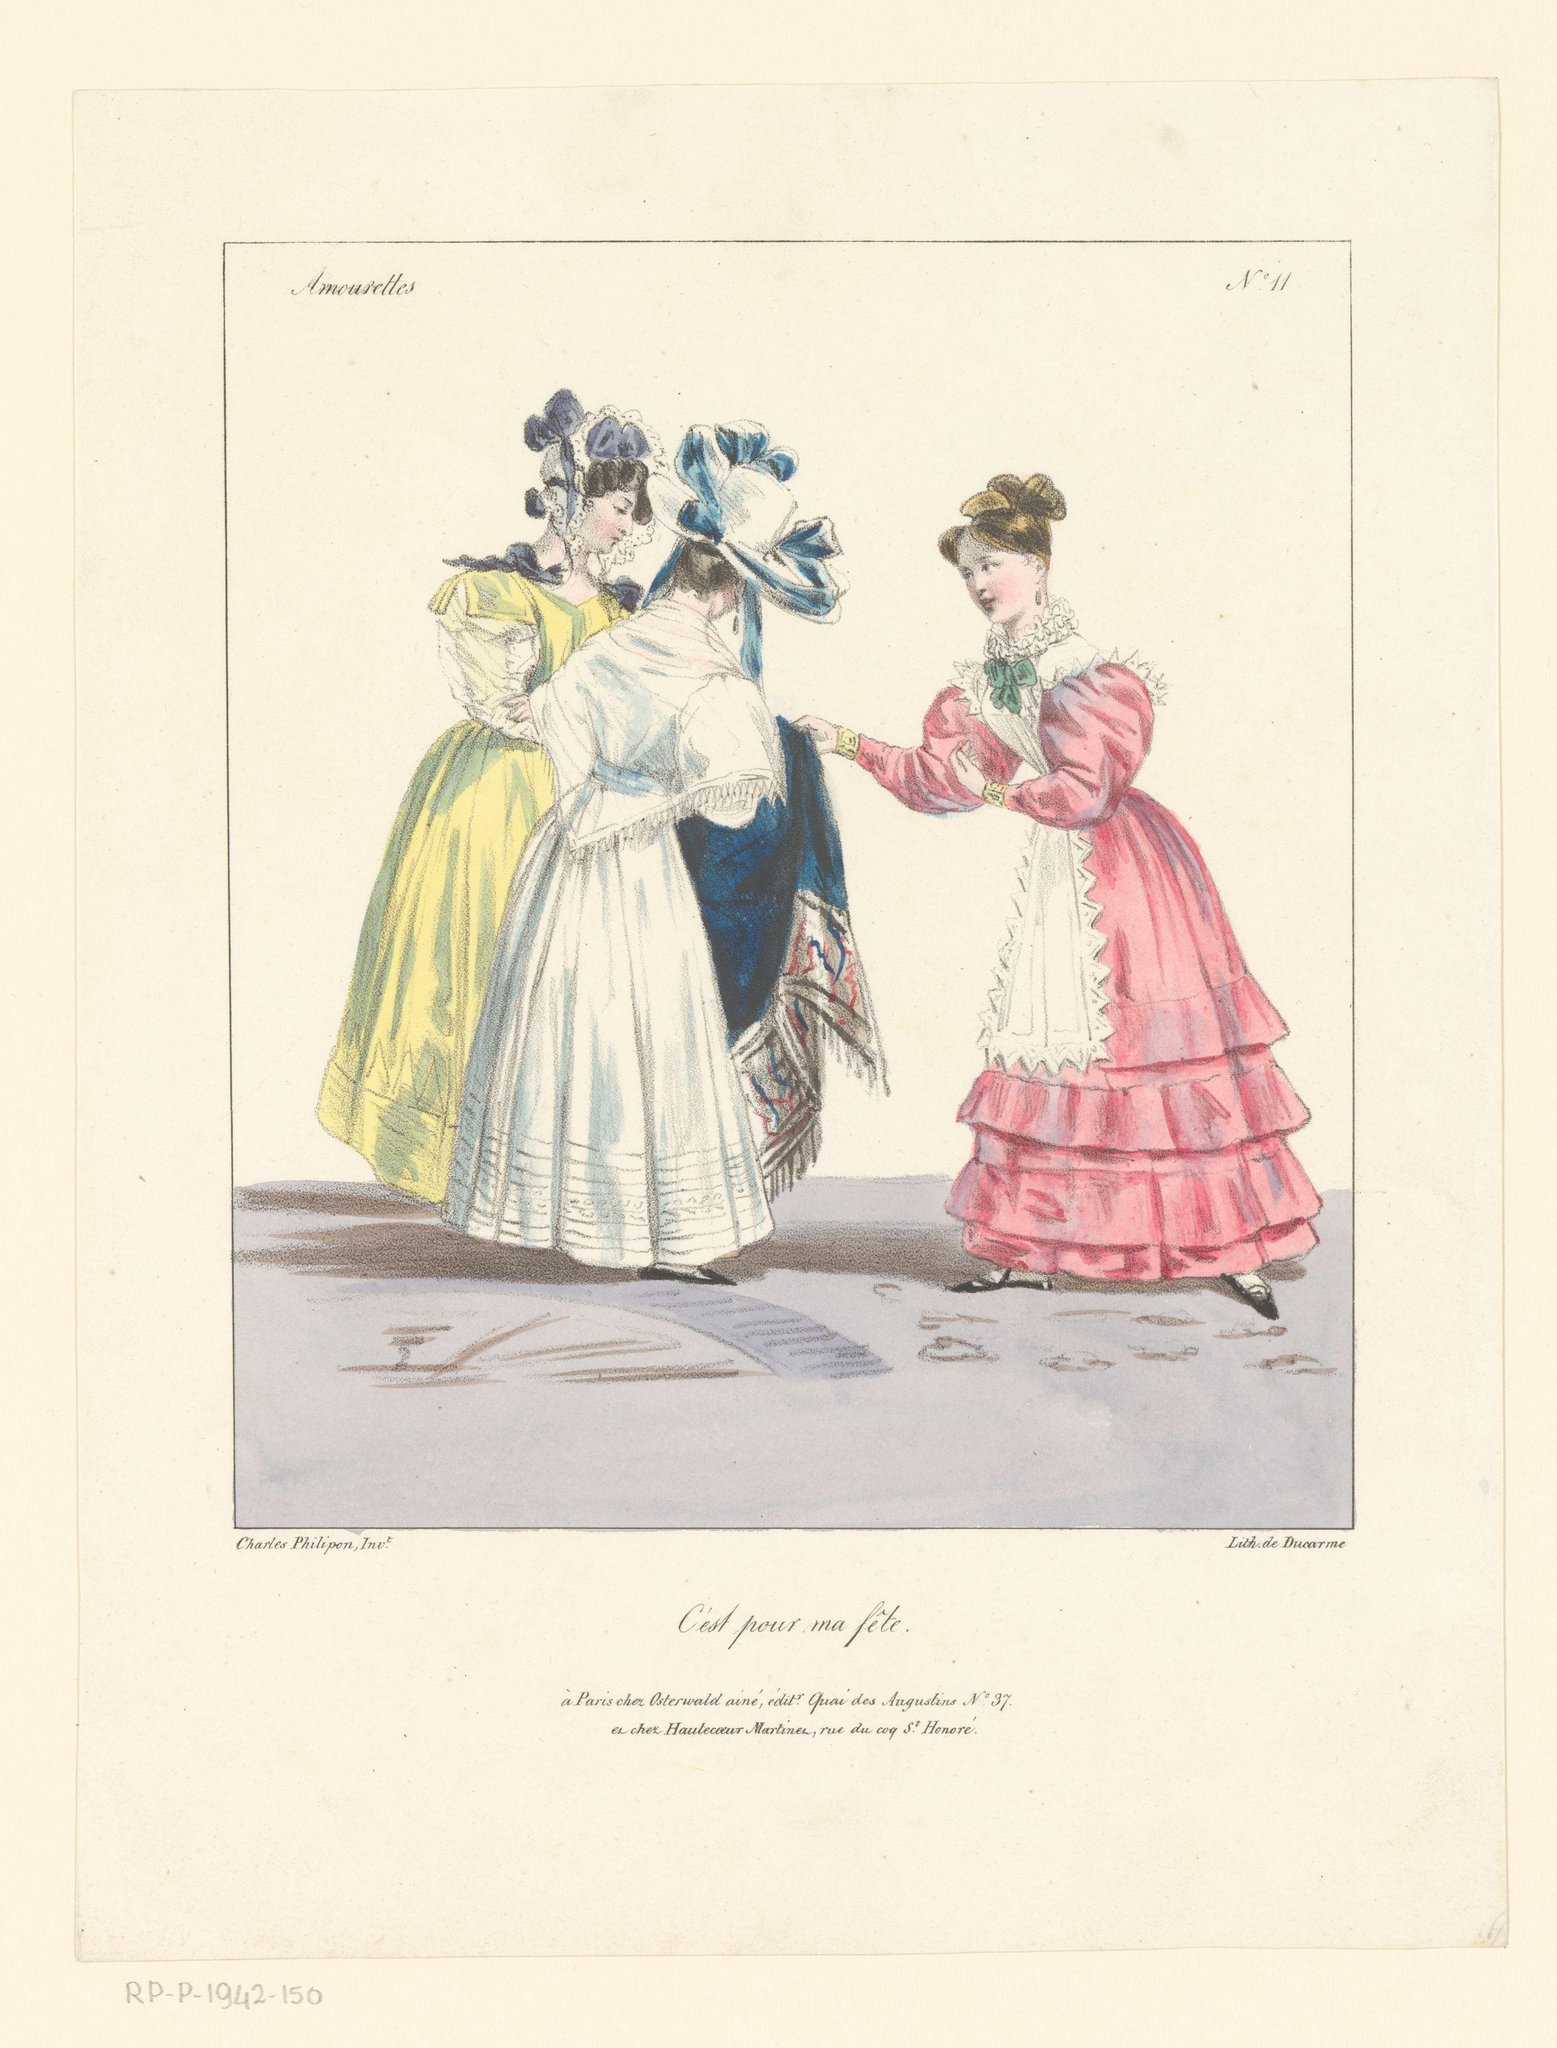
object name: print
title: Amourettes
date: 1827-1829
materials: paper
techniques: hand coloring, lithograph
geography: paris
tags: adult woman, party clothes, festive attire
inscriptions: collector's mark: Lugt 2760, collector's mark: Lugt 2228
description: Serie bestond in eerste instantie uit achttien prenten maar is later uitgebreid, onduidelijk naar hoeveel prenten precies.